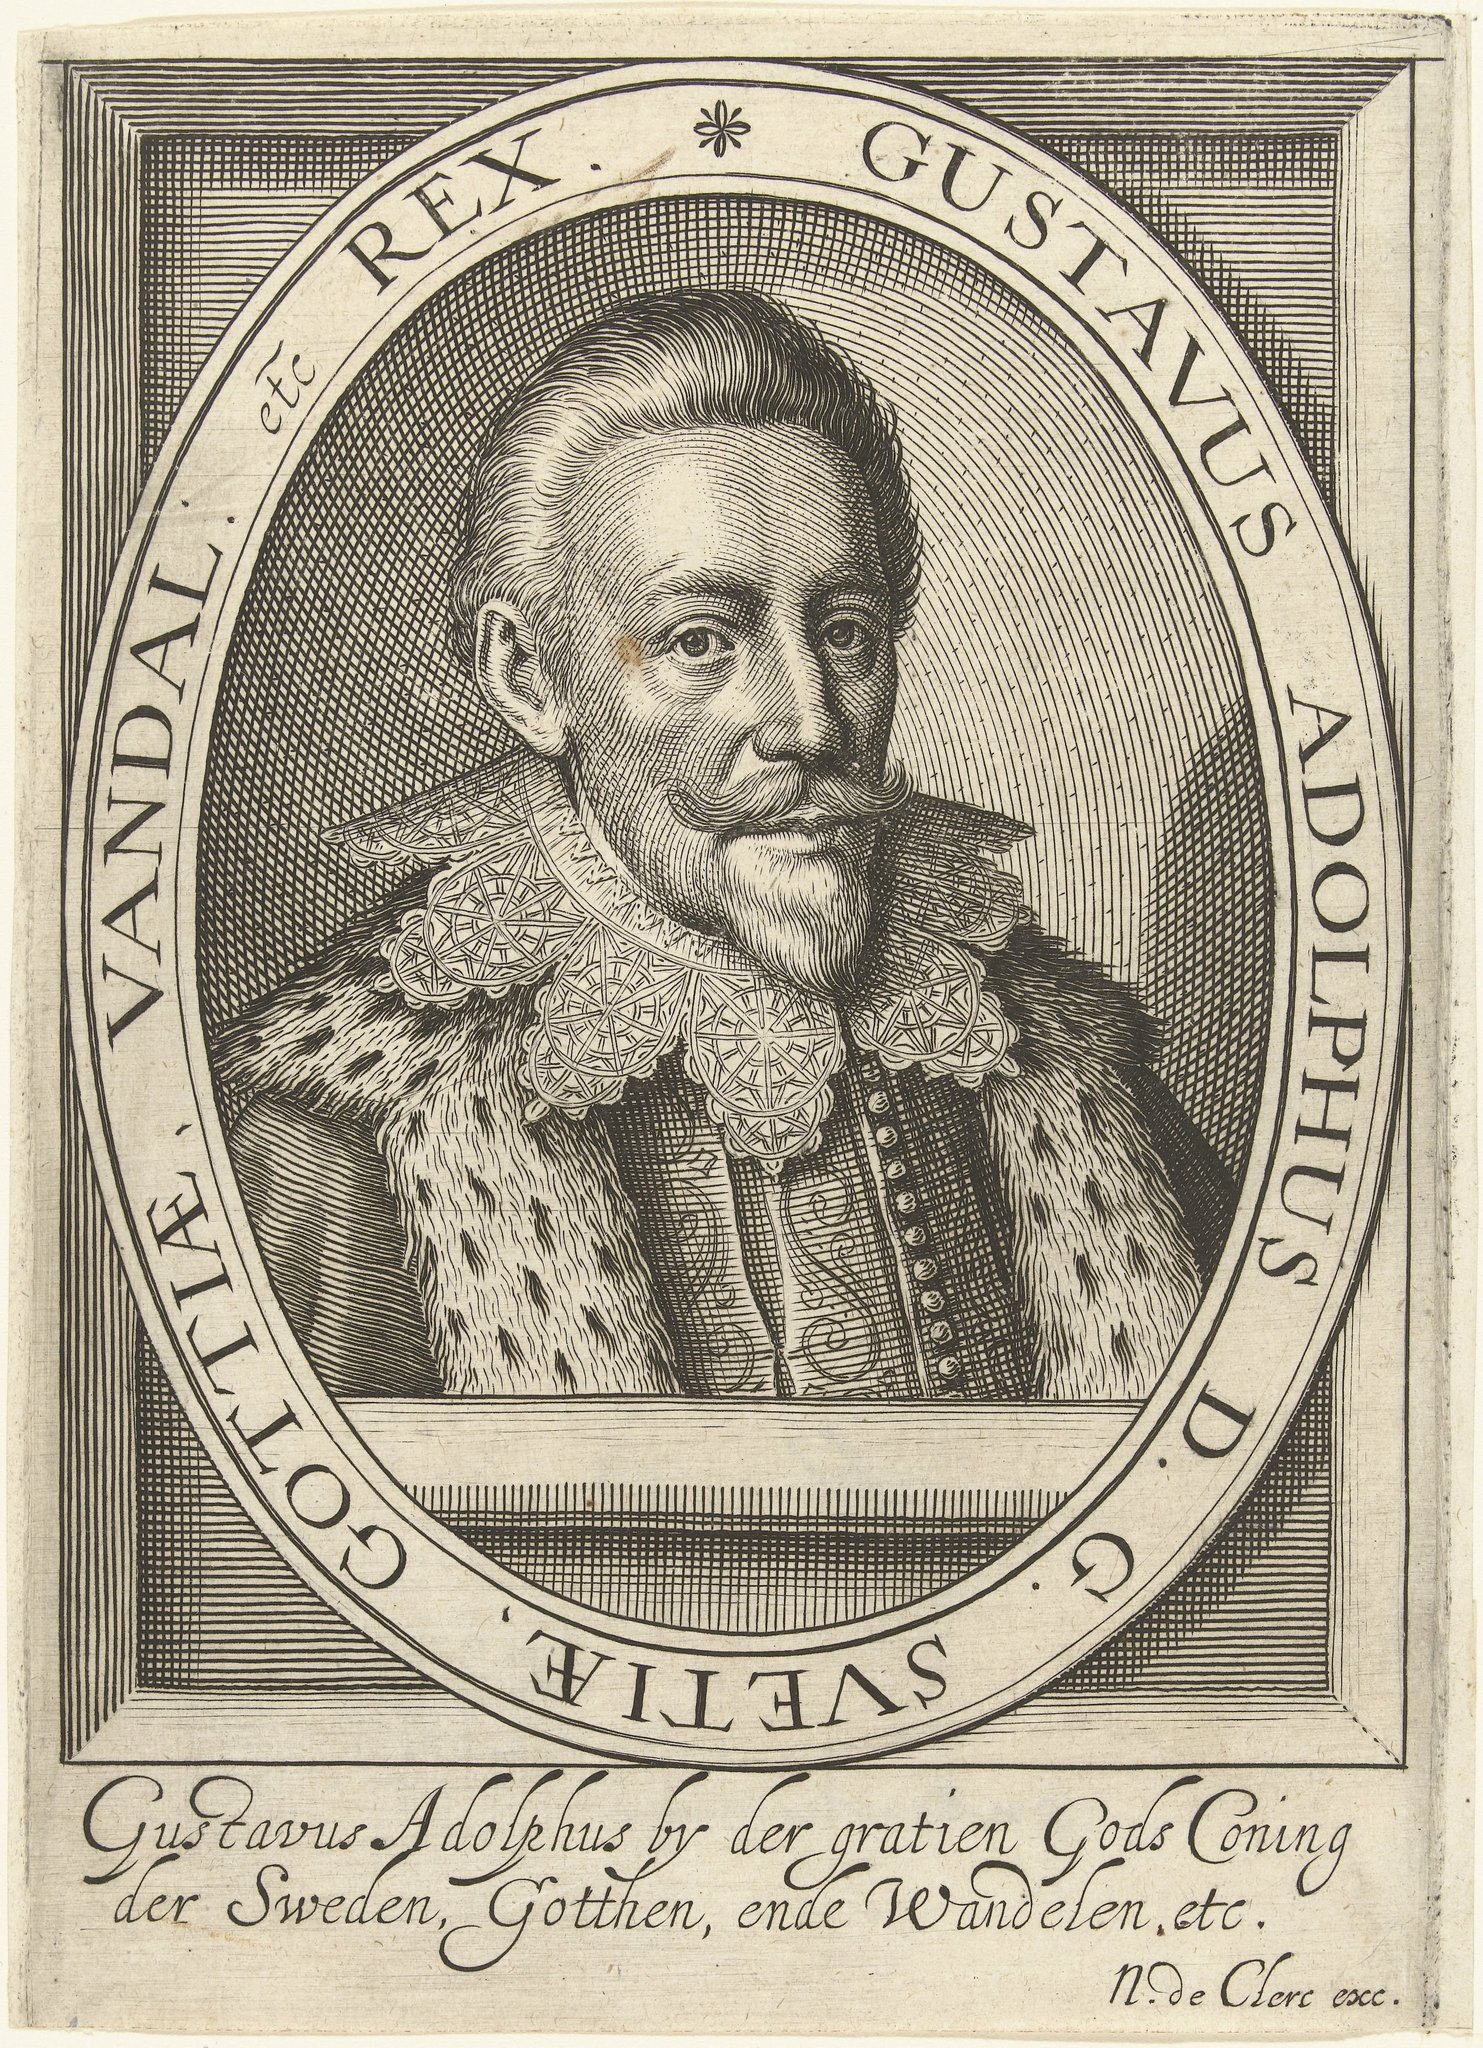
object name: print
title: Portret van Gustaaf II Adolf, koning van Zweden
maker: nicolaes de clerck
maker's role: publisher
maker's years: 1569-1623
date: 1590-1638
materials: paper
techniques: engraving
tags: king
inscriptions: collector's mark: Lugt 2228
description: Portret van Gustaaf II Adolf, koning van Zweden, borststuk met kanten kraag en nertsmantel in ovale omlijsting met Latijns opschrift. In ondermarge twee regels Nederlandse tekst.